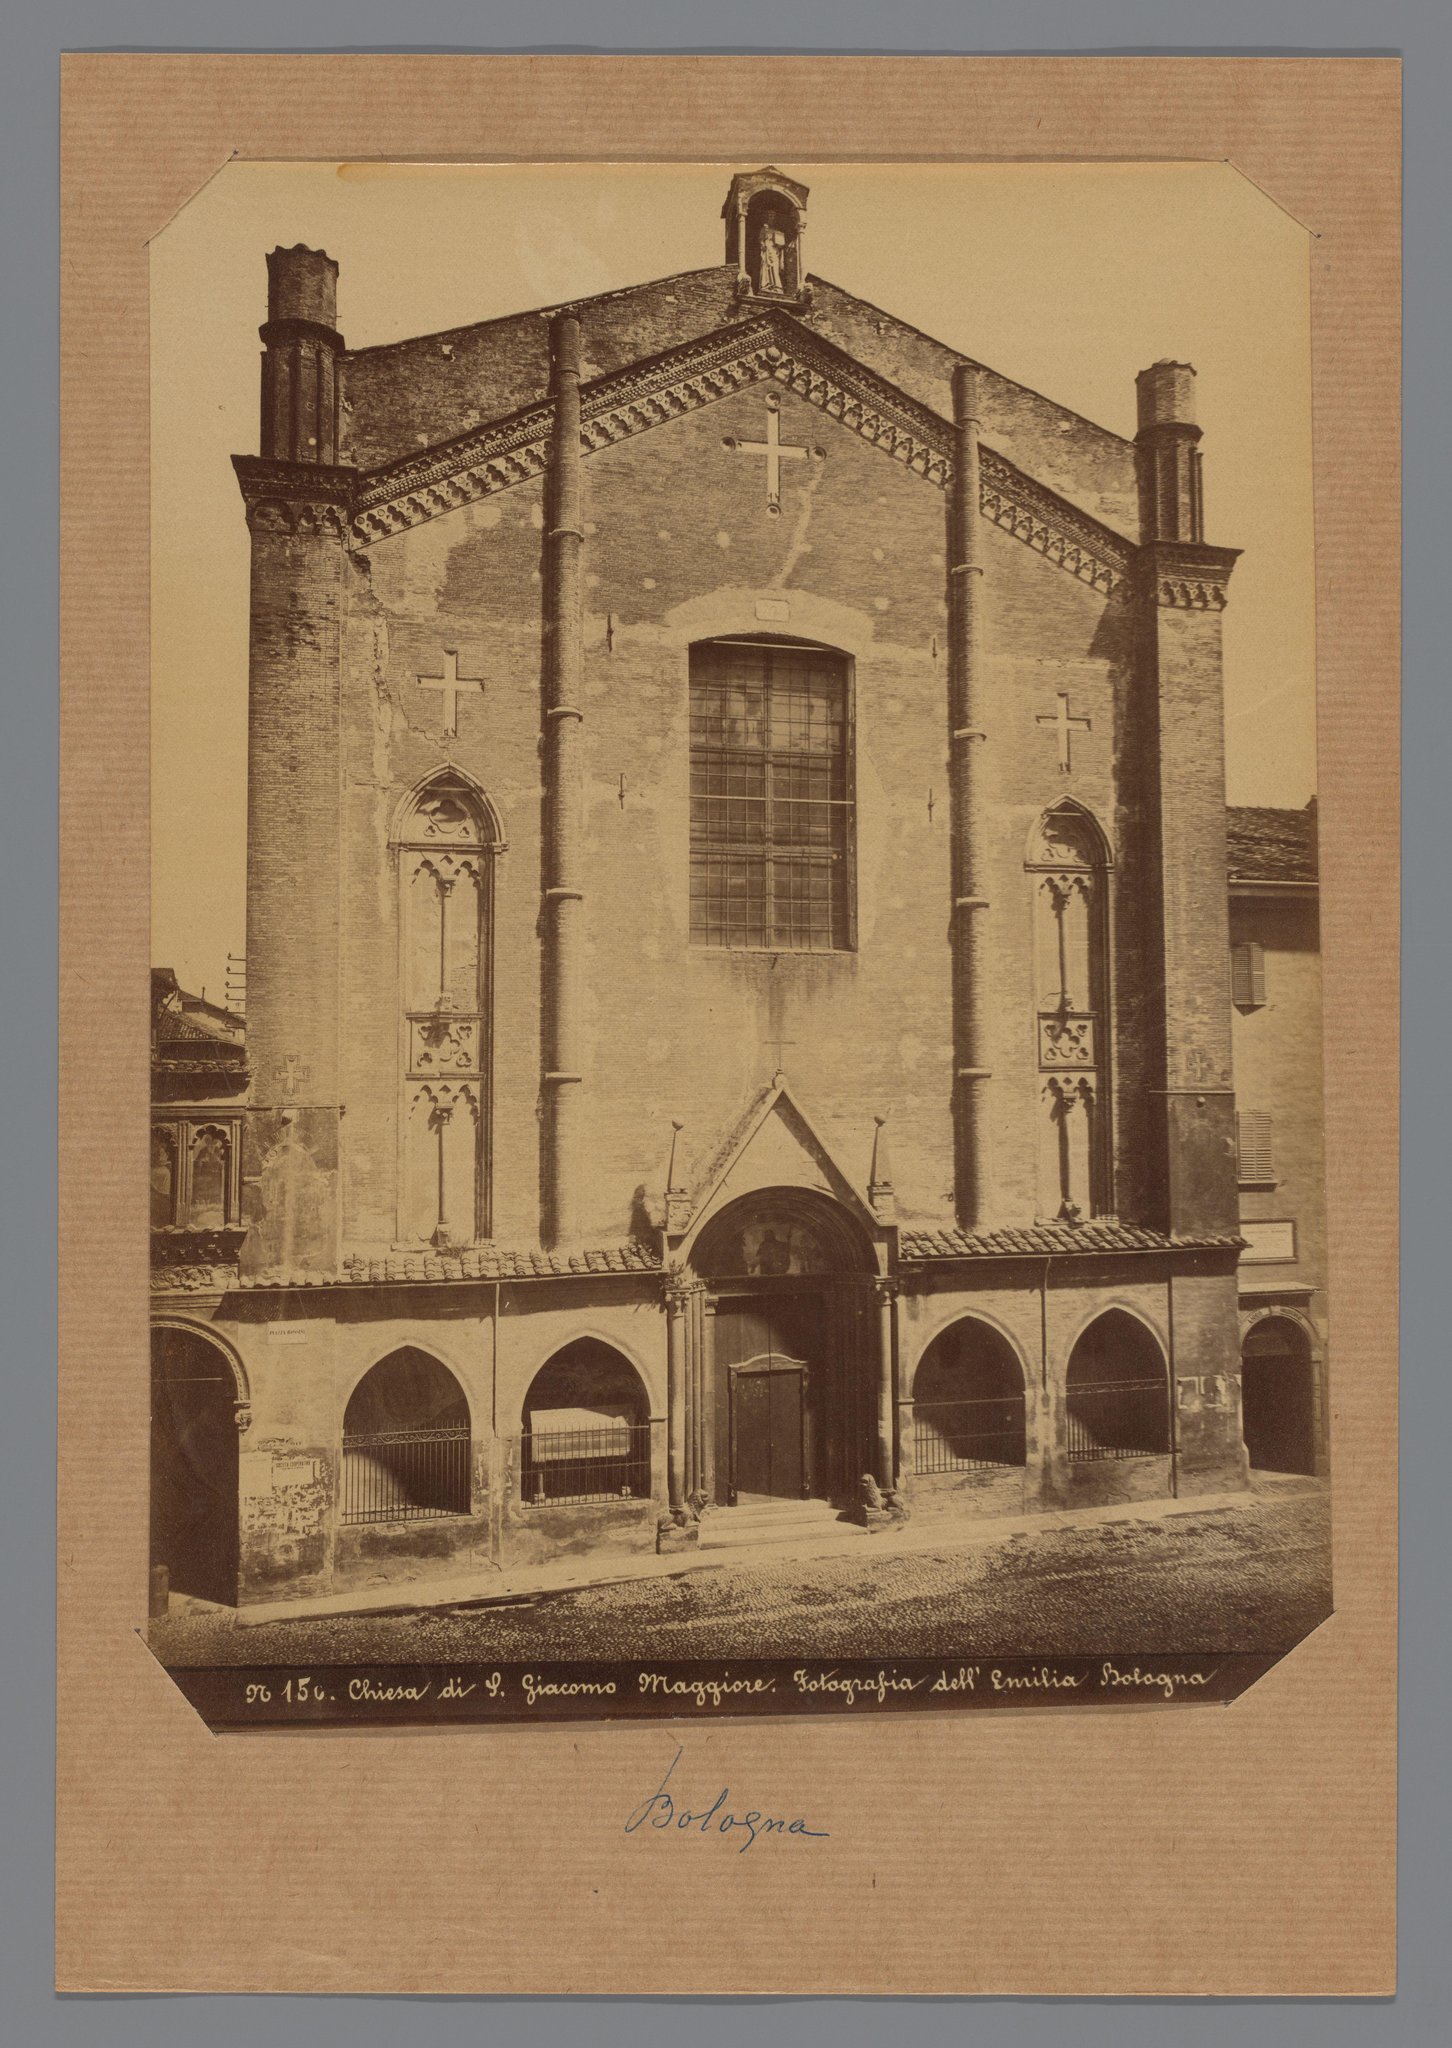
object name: photograph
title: Italië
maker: Anonymous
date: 1880-1910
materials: photographic support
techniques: albumen print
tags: italy